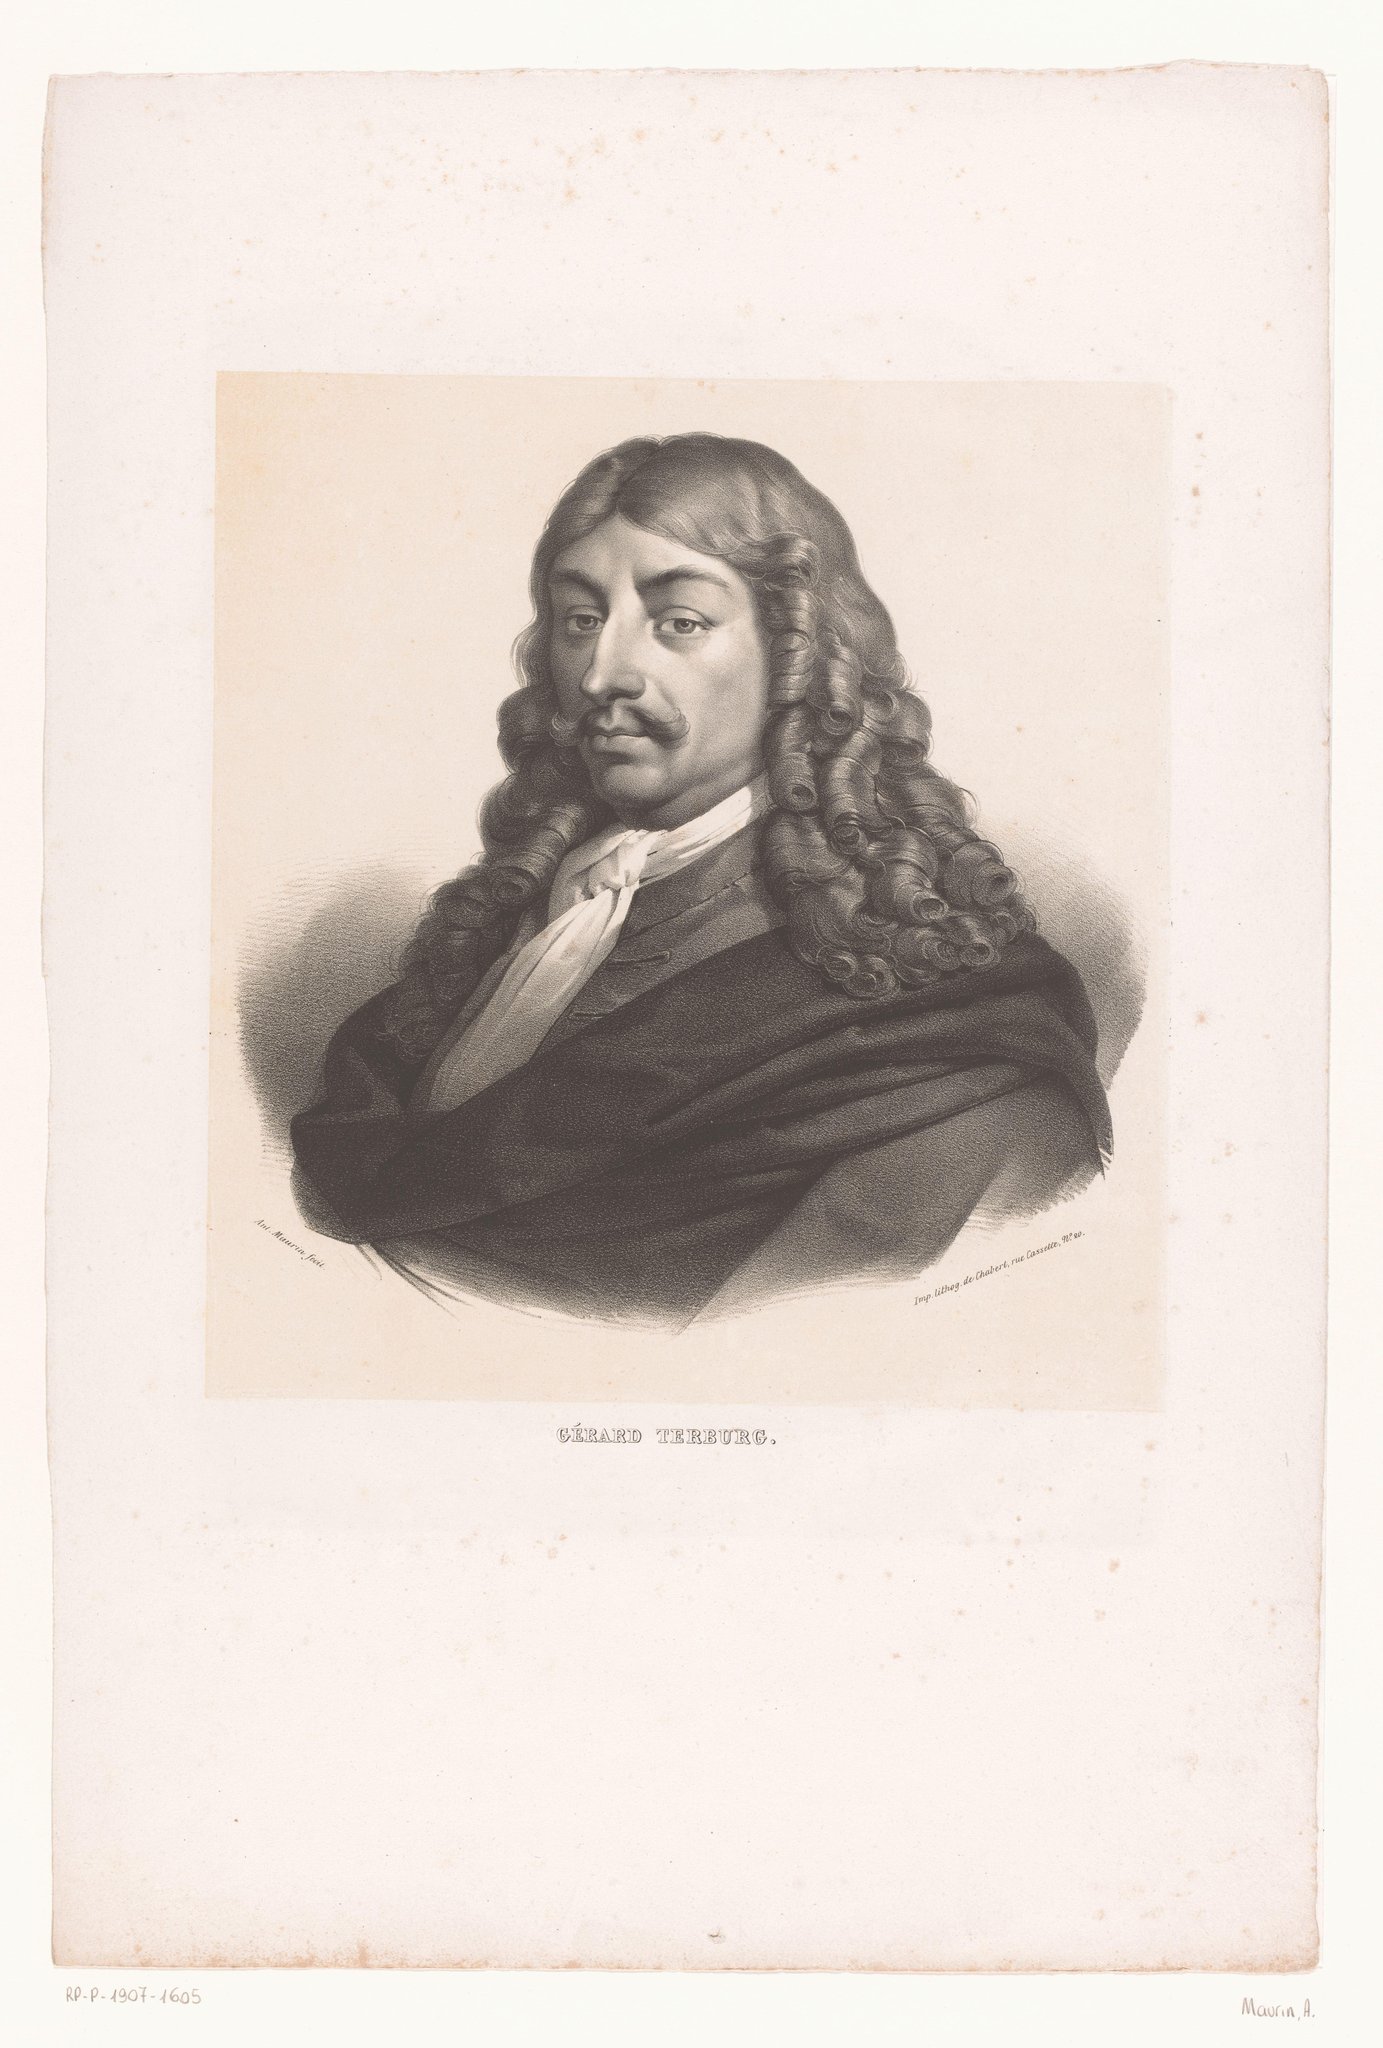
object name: print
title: Gérard Terburg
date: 1827-1854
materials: paper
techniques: tone lithography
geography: paris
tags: deventer, painter, draughtsman, gerard ter borch (ii), historical persons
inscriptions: collector's mark: Lugt 2228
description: Prent ook gebruikt in: Chabert, Jean Claude. Galerie des peintres ou collection de portraits des peintres les plus célèbres de toutes les écoles. Accompagnée d'une notice sur chacun d'eux, et de copies de dessins originaux / Galerie des peintres ou collection de portraits des peintres les plus célèbres de toutes les écoles. Accompagnée de leur notice historique, de leurs dessins et d'un discours sur les arts. Parijs: Jean Claude Chabert, s.a. [1822-1834]. De samenstelling van tegenwoordig bekende en al dan niet gebonden exemplaren van deze uitgave verschillen. Dit omdat de prenten en bijhorende stukken tekst op inschrijving en waarschijnlijk ook los verkrijgbaar waren.